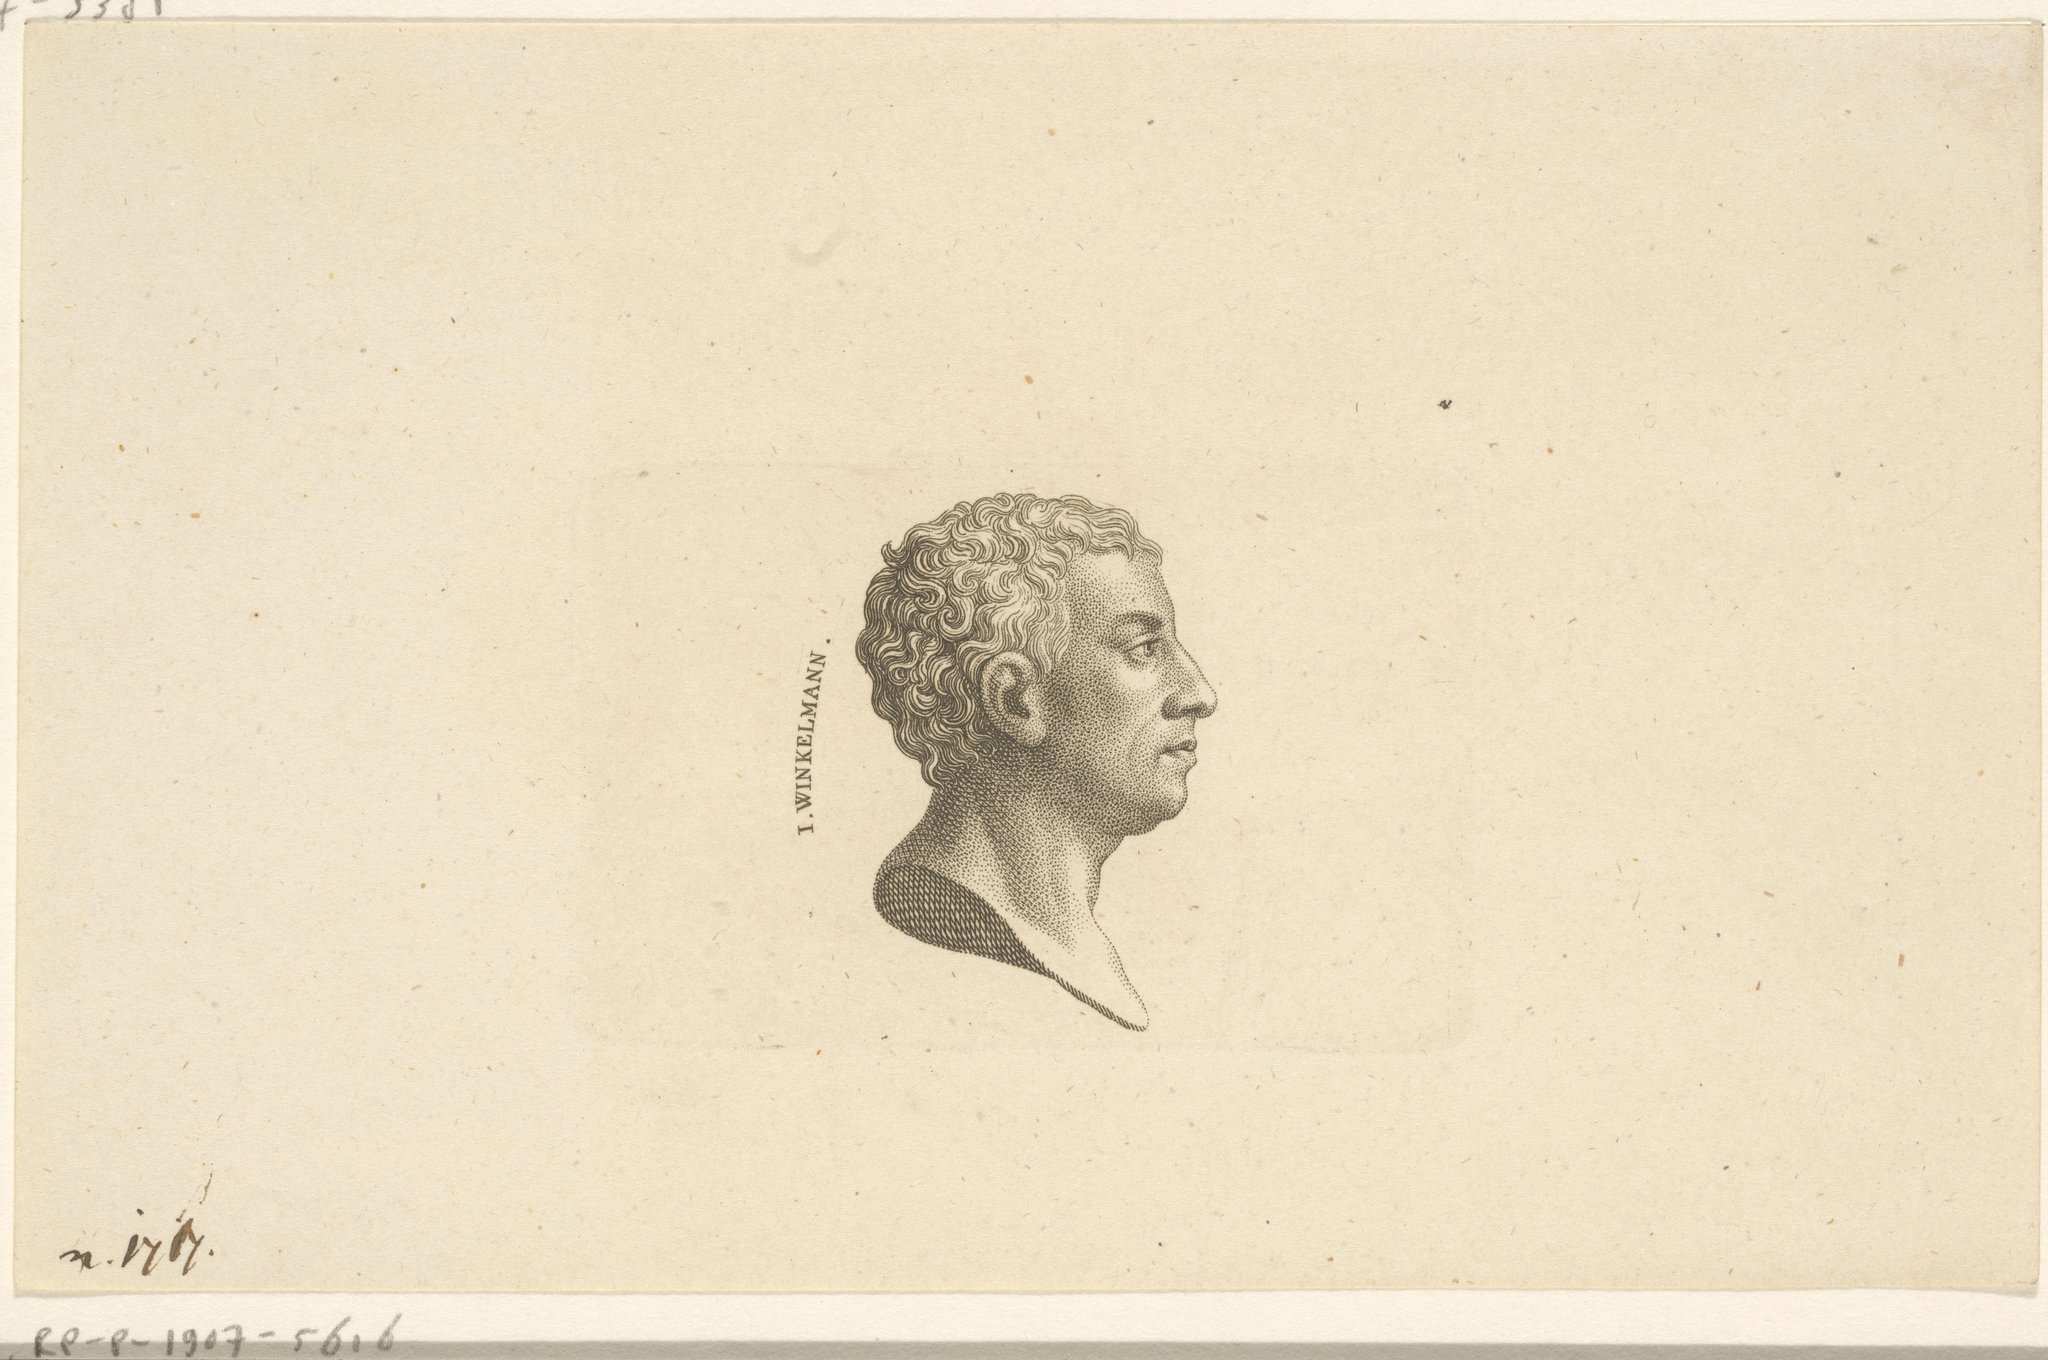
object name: print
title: Portret van Johann Joachim Winckelmann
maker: ernst ludwig riepenhausen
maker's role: print maker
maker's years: 1765-1840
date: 1775-1840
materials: paper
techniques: engraving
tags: historical persons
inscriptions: date, collector's mark: Lugt 2228